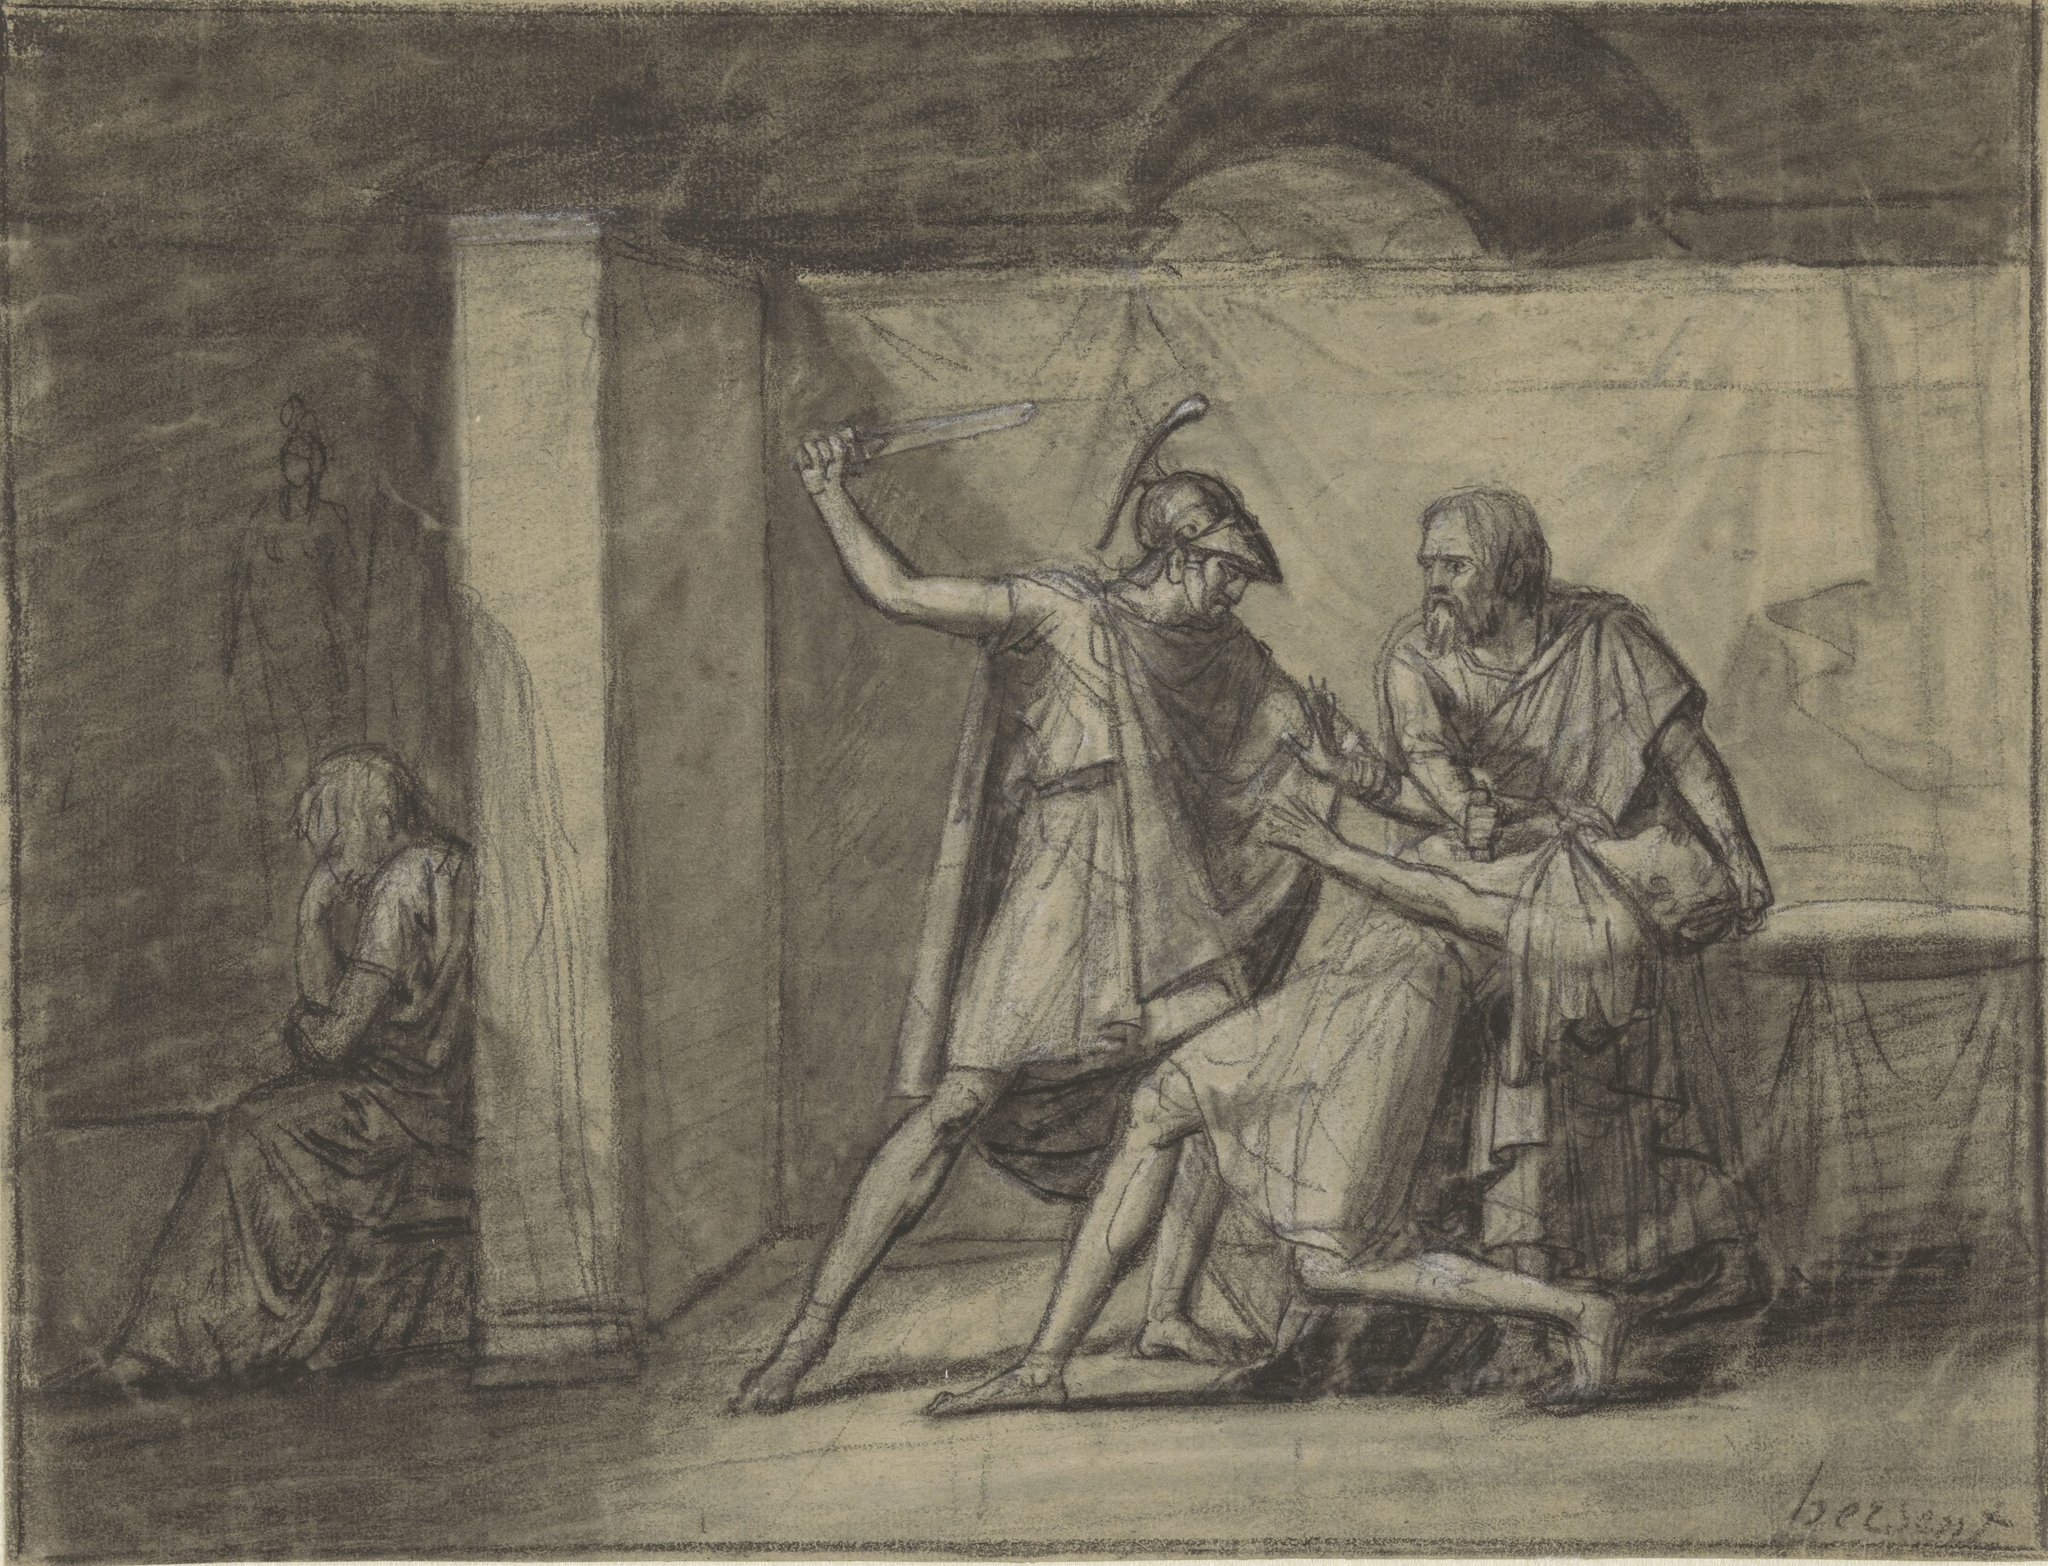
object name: drawing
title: De dood van Julius Caesar(?)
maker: louis hersent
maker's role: painter, print maker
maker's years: 1777-1860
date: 1787-1860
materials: chalk, paper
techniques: brush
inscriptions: signature: ‘hersent’